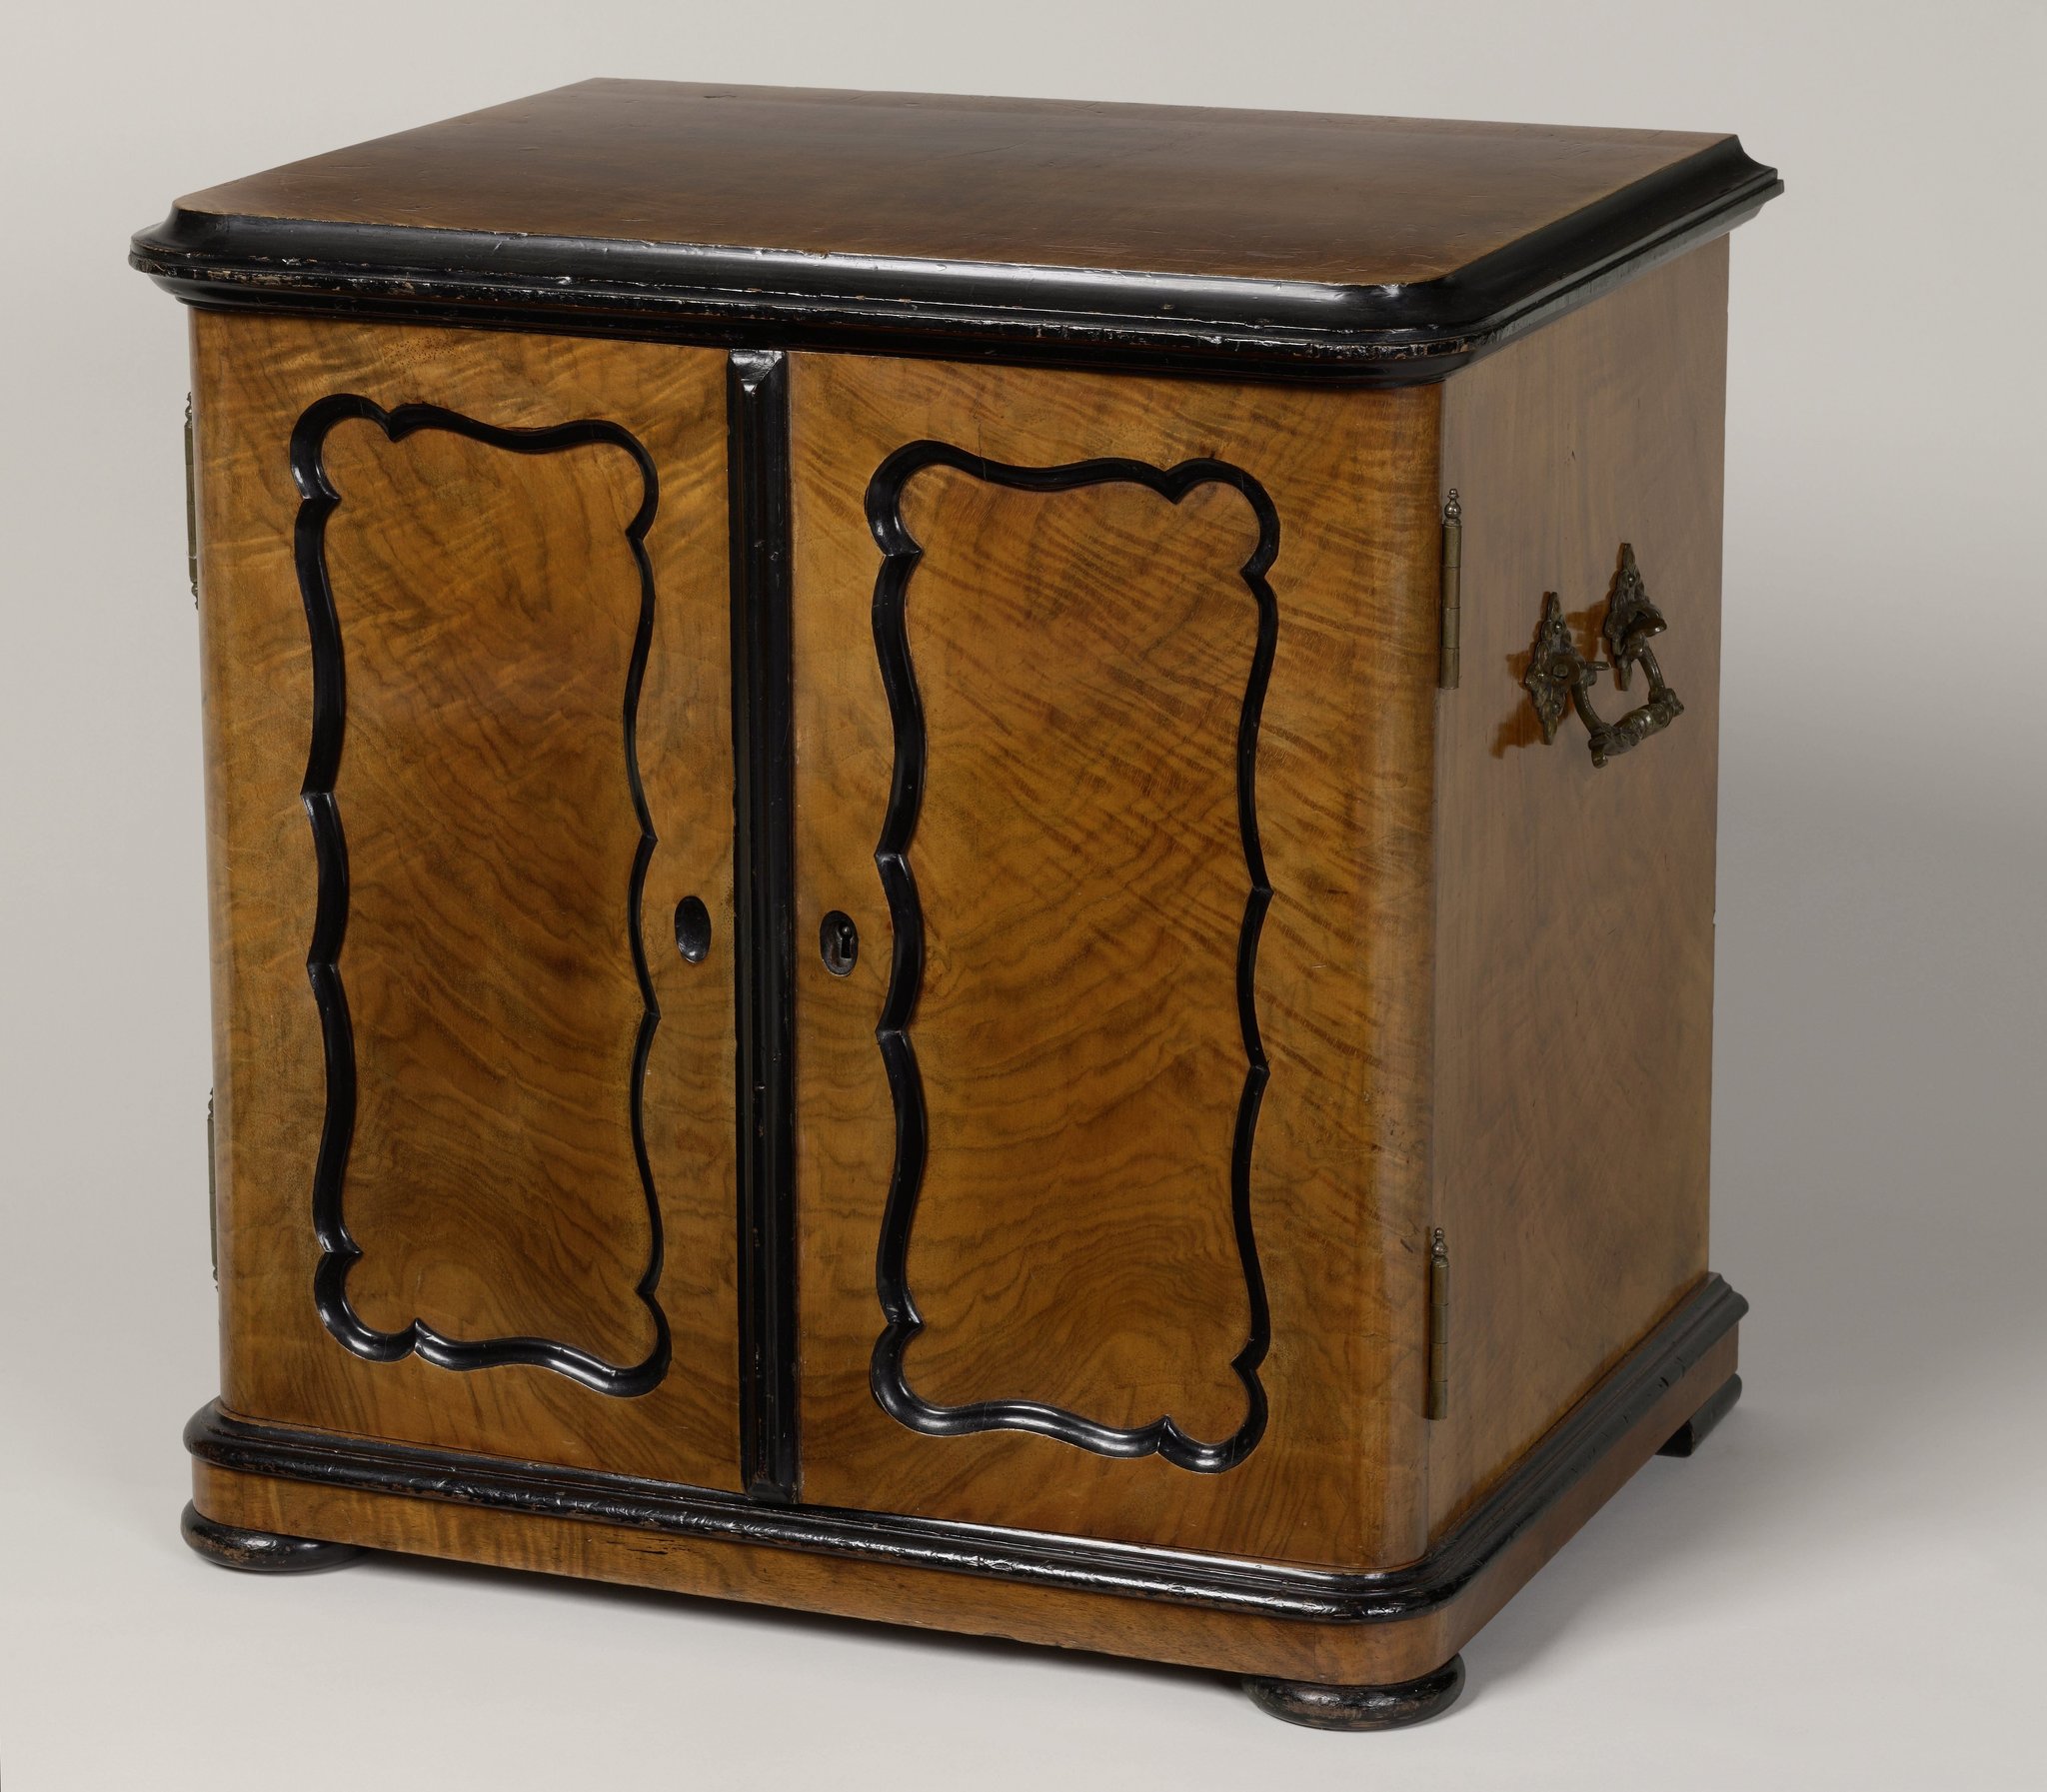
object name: cabinet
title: Prentenkabinet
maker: Anonymous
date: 1895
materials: wood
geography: netherlands